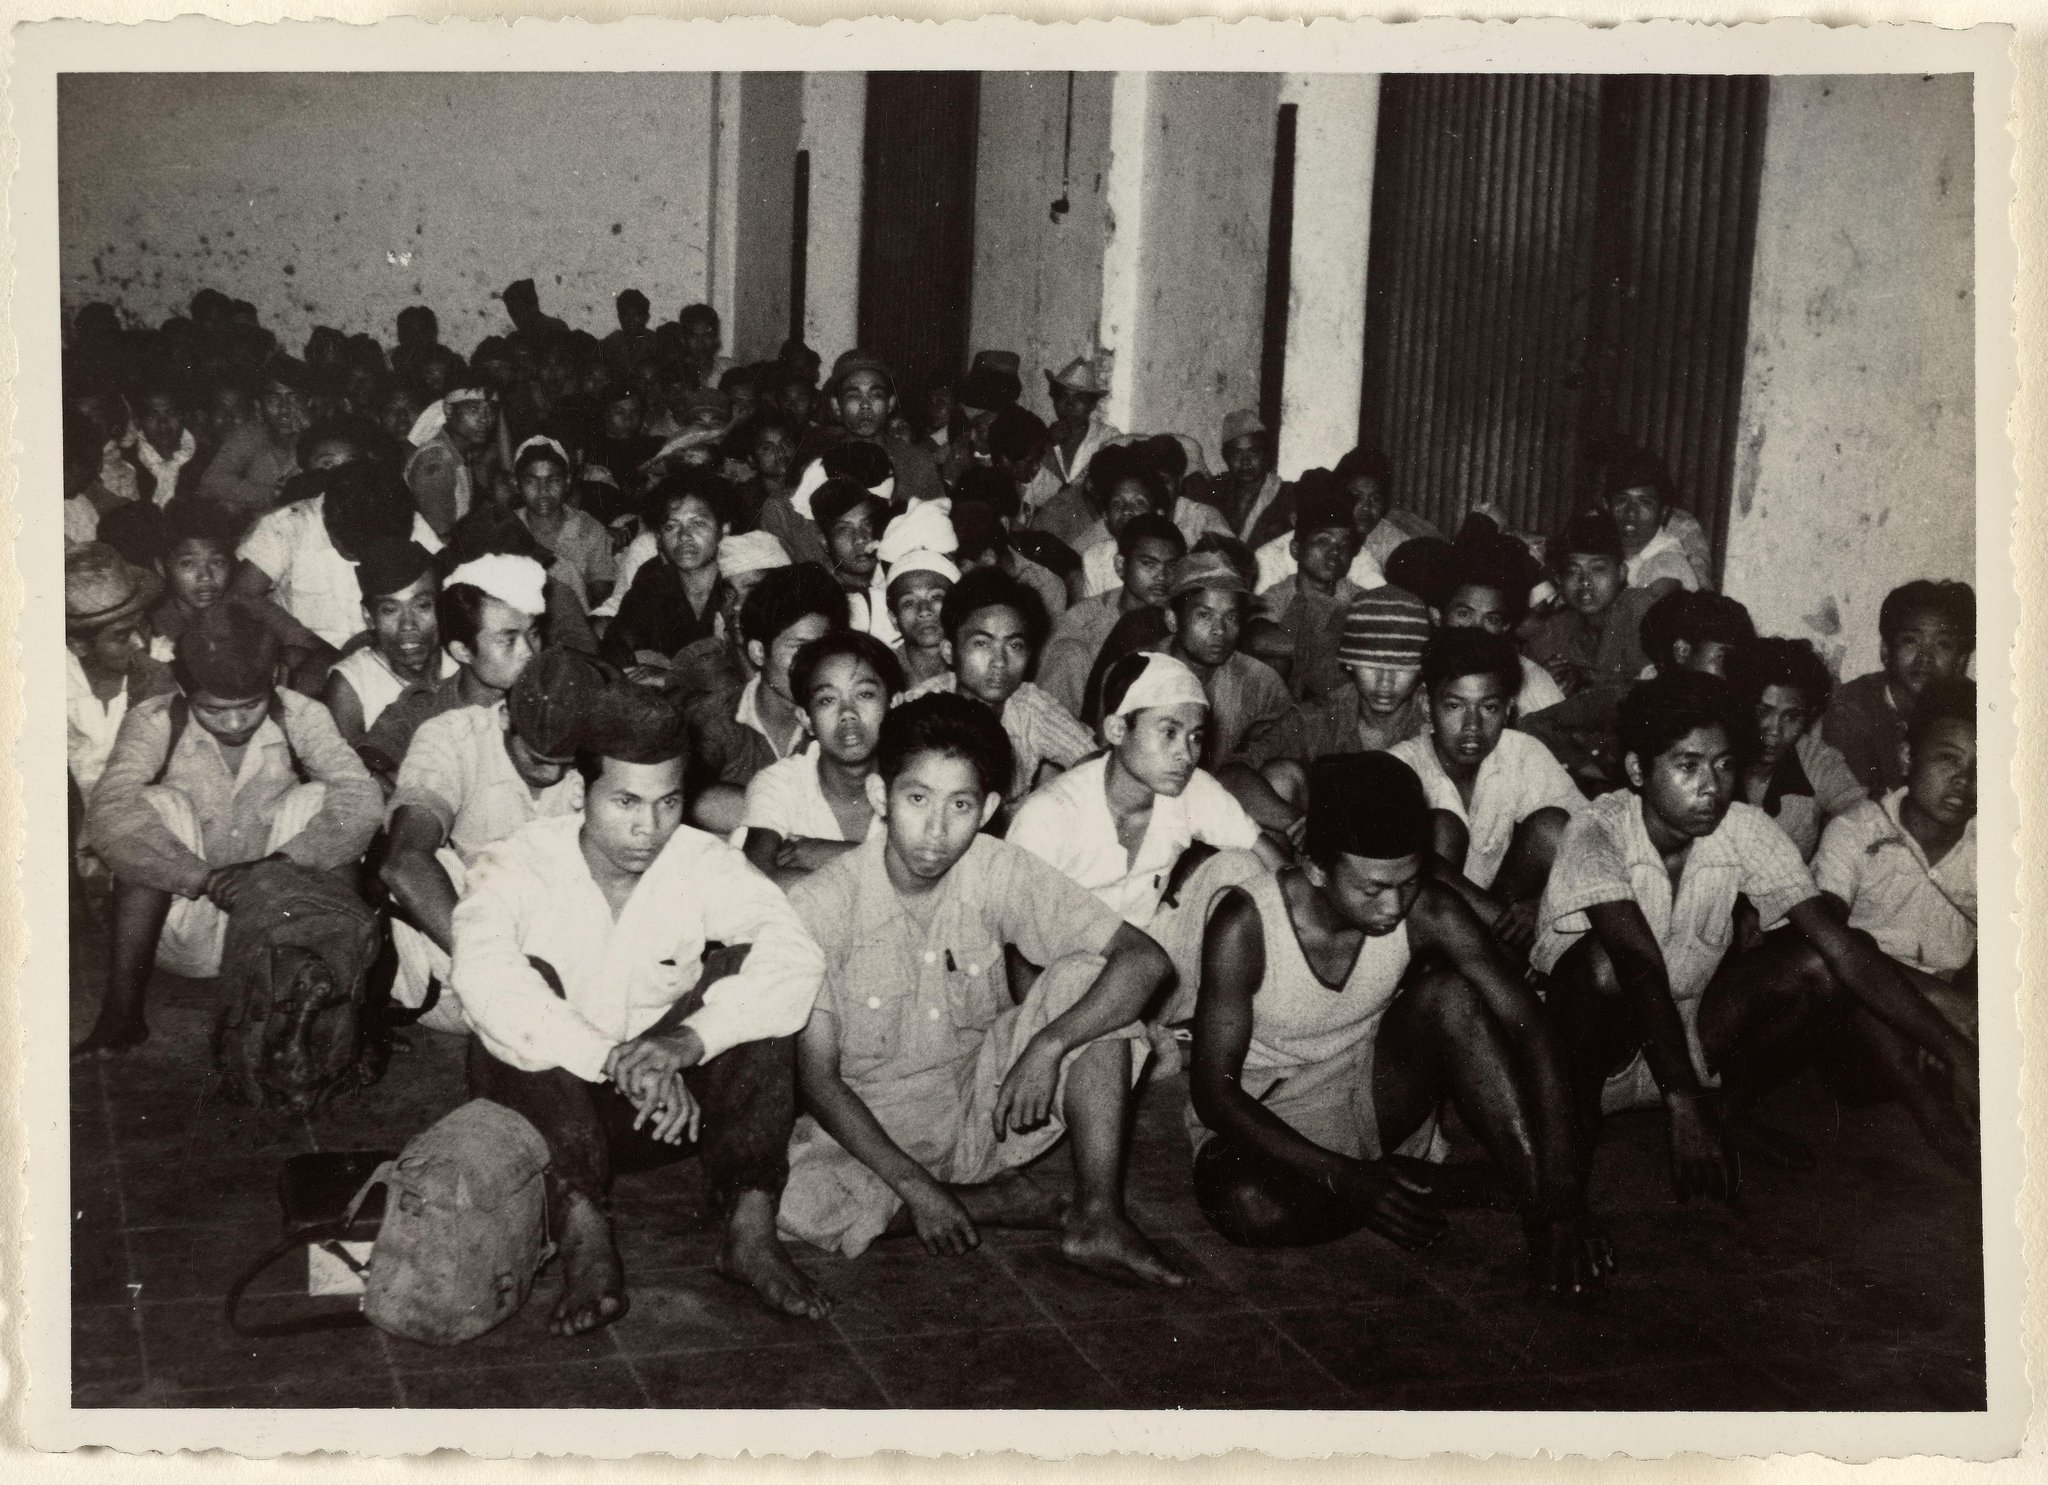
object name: documentary photograph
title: Grote groep zittende Indonesiërs: het leger van Soekarno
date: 1945-1949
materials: photographic support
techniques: photography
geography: batavia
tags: batavia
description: Circa tachtig Indonesiërs zitten opgepropt in een kleine ruimte. Het leger van Soekarno.